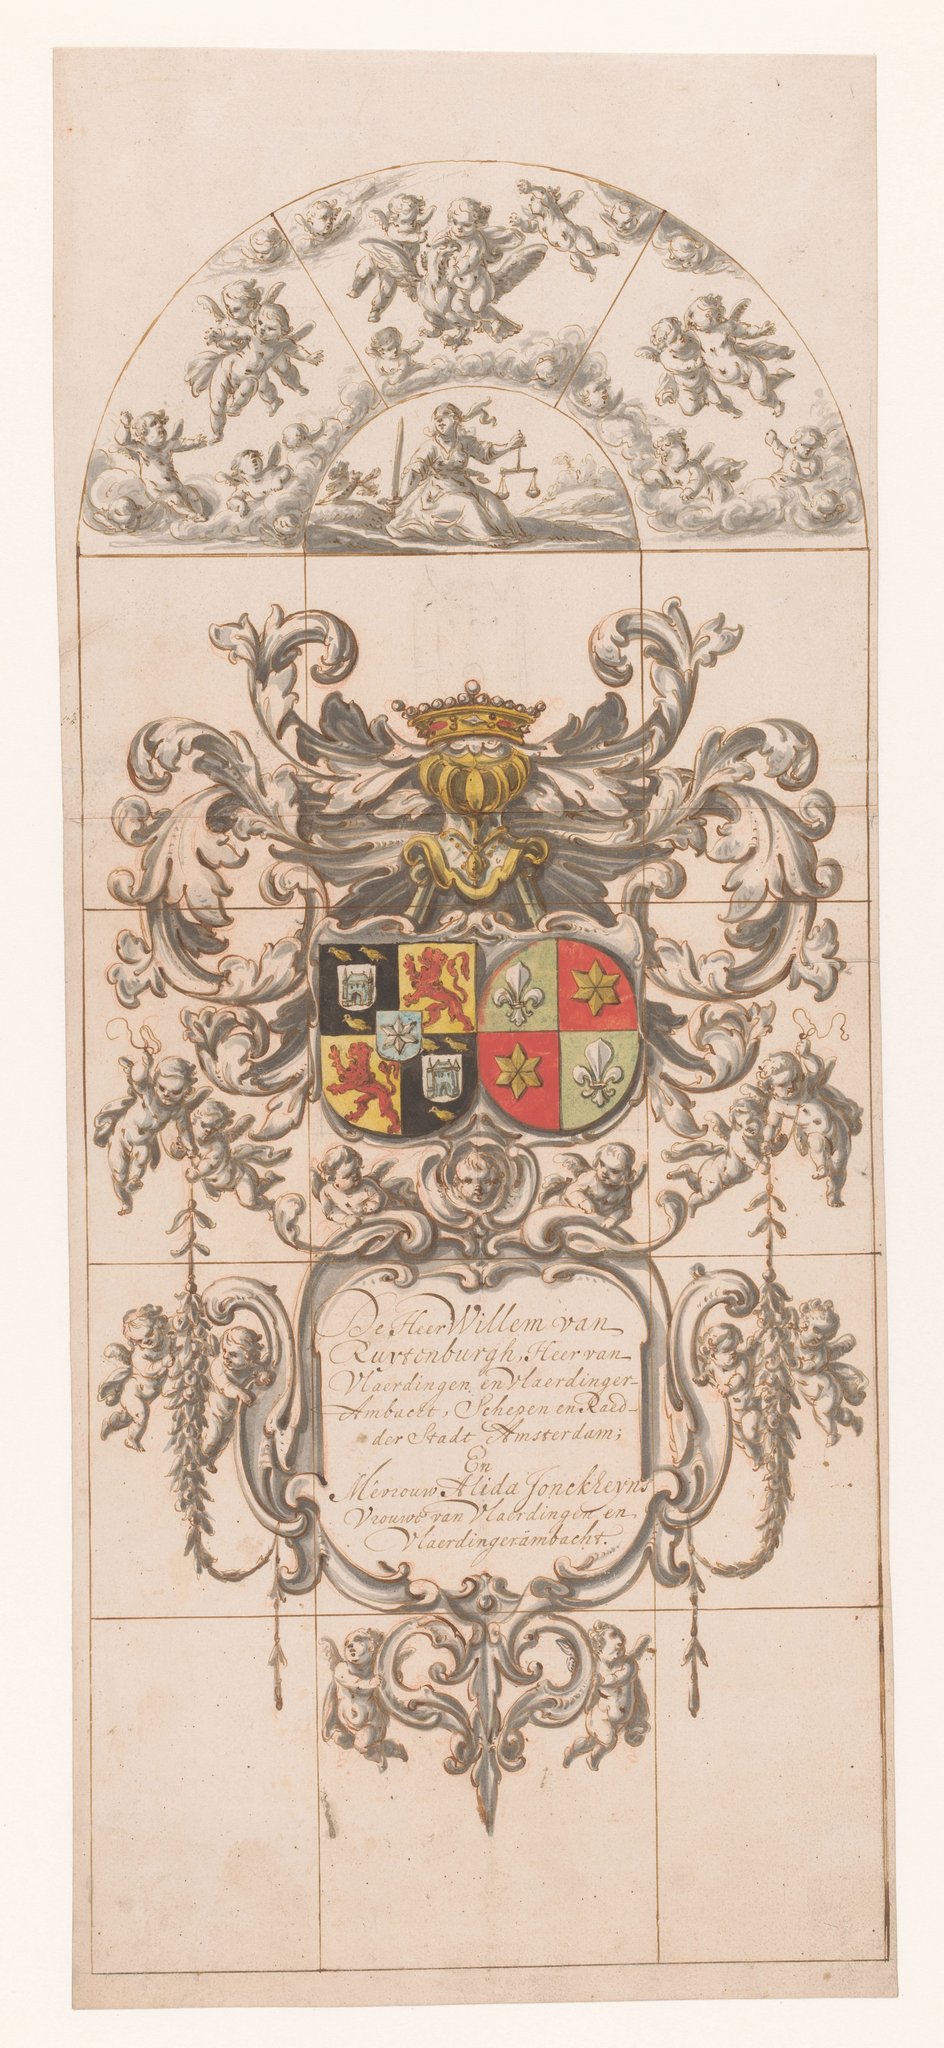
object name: design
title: Ontwerp voor glasraam twaalf in kerk te Oudshoorn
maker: pieter jansz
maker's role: draughtsman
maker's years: 1602-1672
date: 1663-1667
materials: chalk, ink, paper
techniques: brush, pen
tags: justice, 'justitia'; 'giustitia divina' (ripa) ~ one of the four cardinal virtues, church-window, e.g. rose-window, armorial bearing, heraldry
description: Boven Justitia omringd door putti, in het midden het alliantiewapen van Willem van Ruytenburgh, heer van Vlaardingen en Alida Jonckheyn.